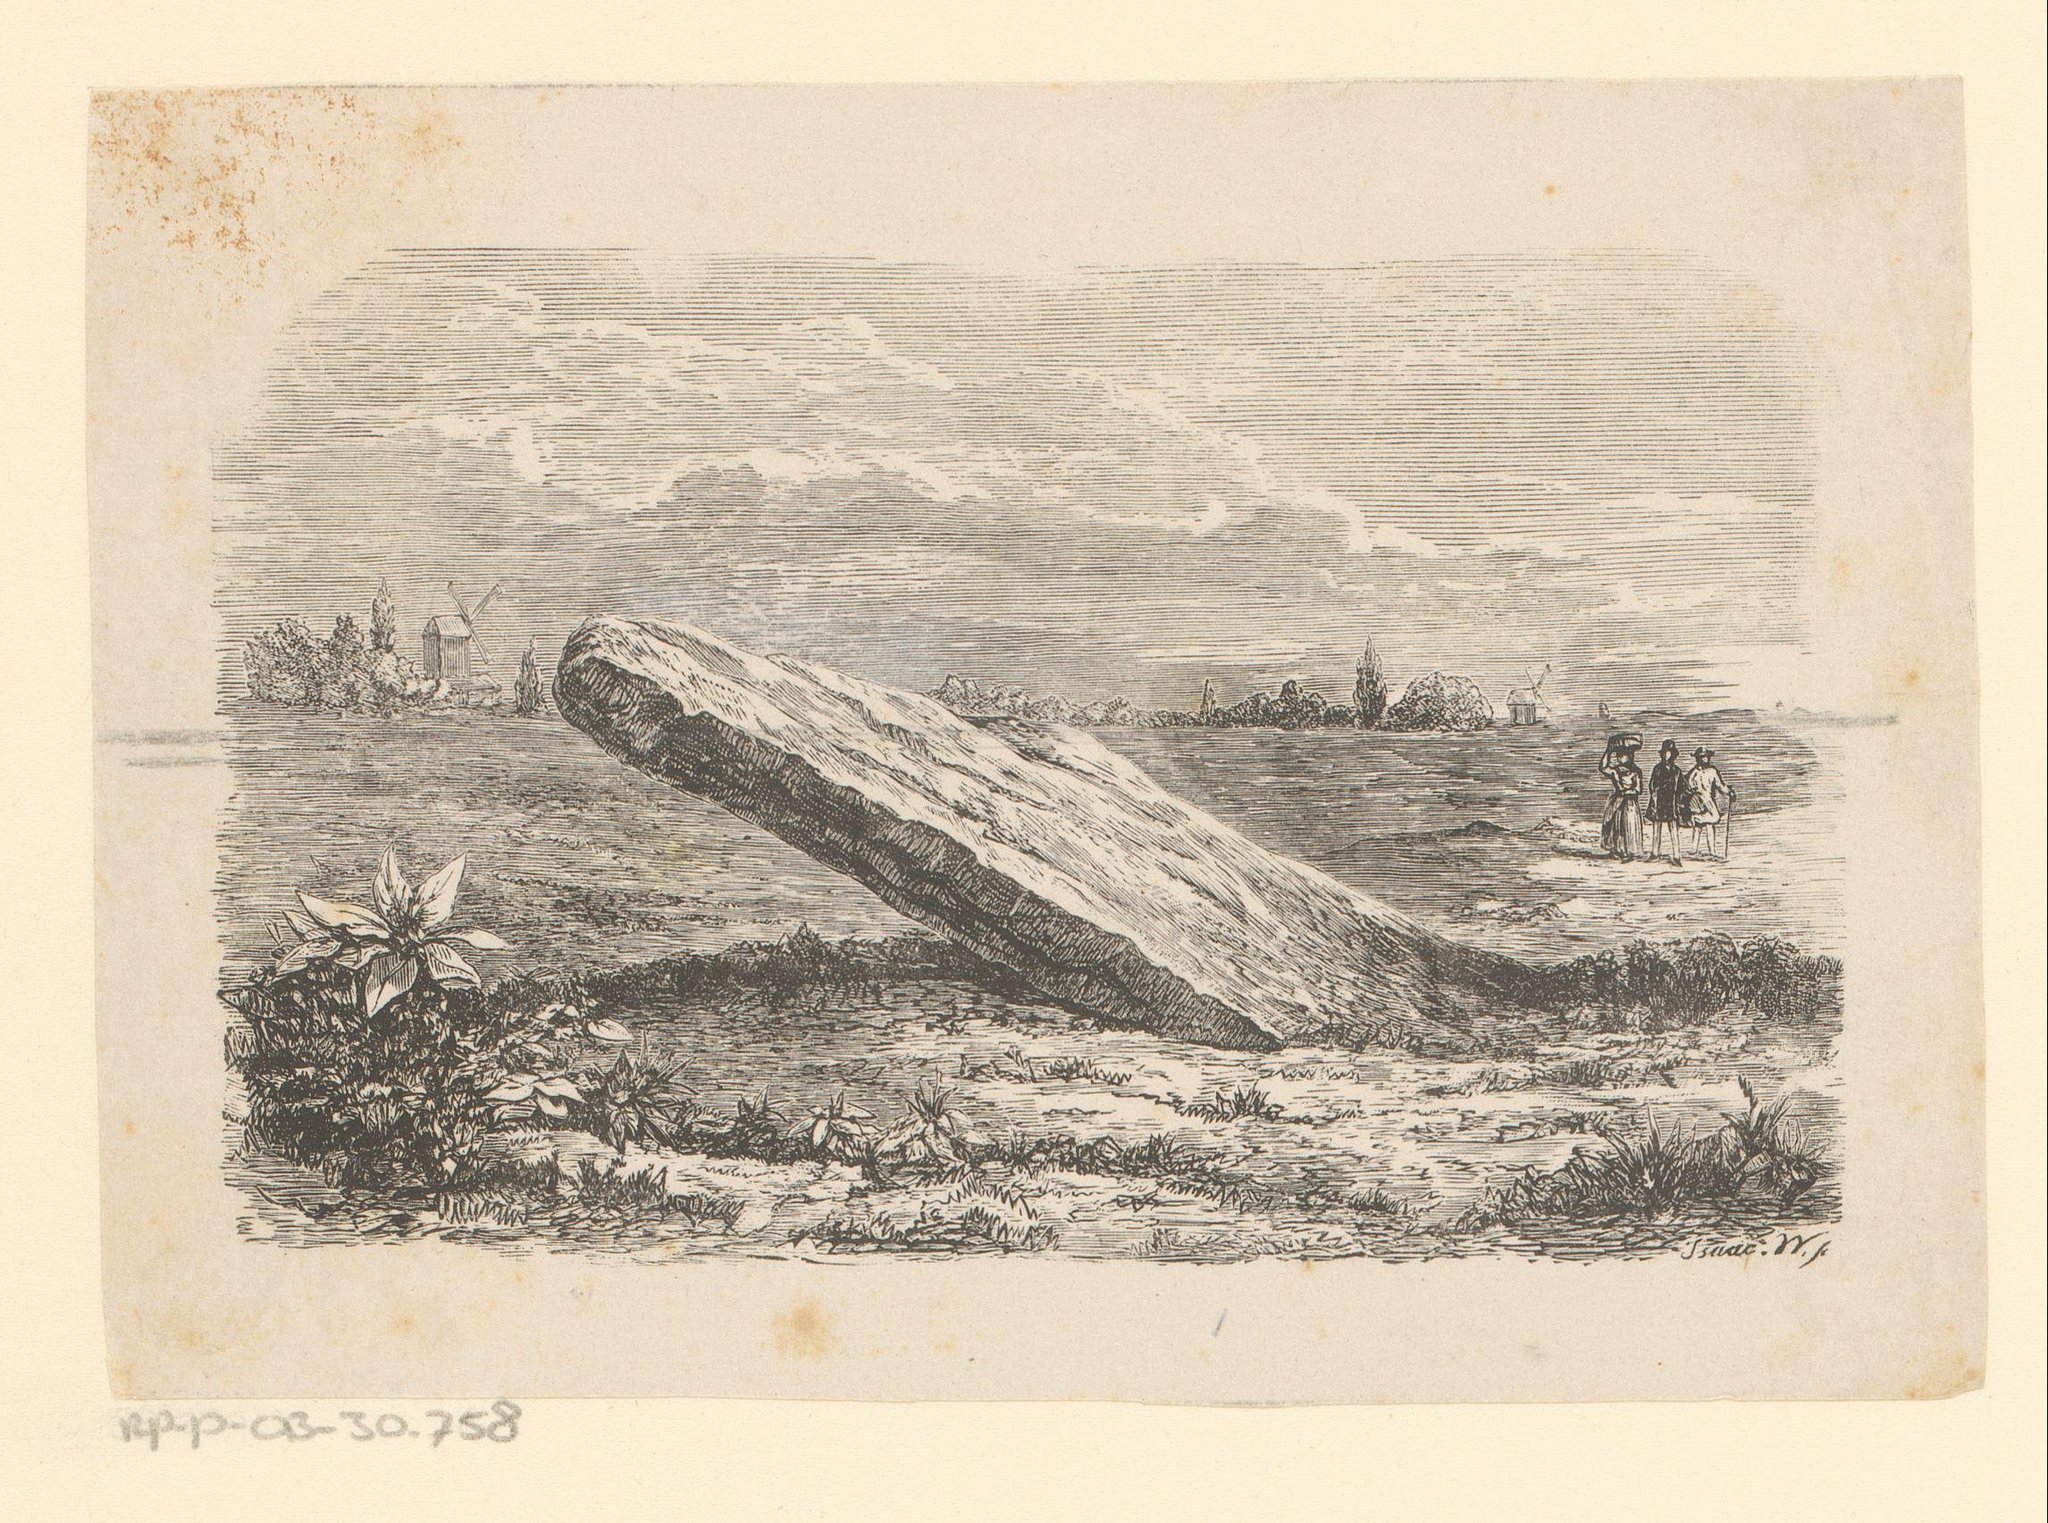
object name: print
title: Landschap met een diagonale steen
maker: isaac weissenbruch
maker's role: print maker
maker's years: 1826-1912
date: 1836-1912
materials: paper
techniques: engraving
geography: netherlands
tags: landscapes (+ landscape with figures, staffage)